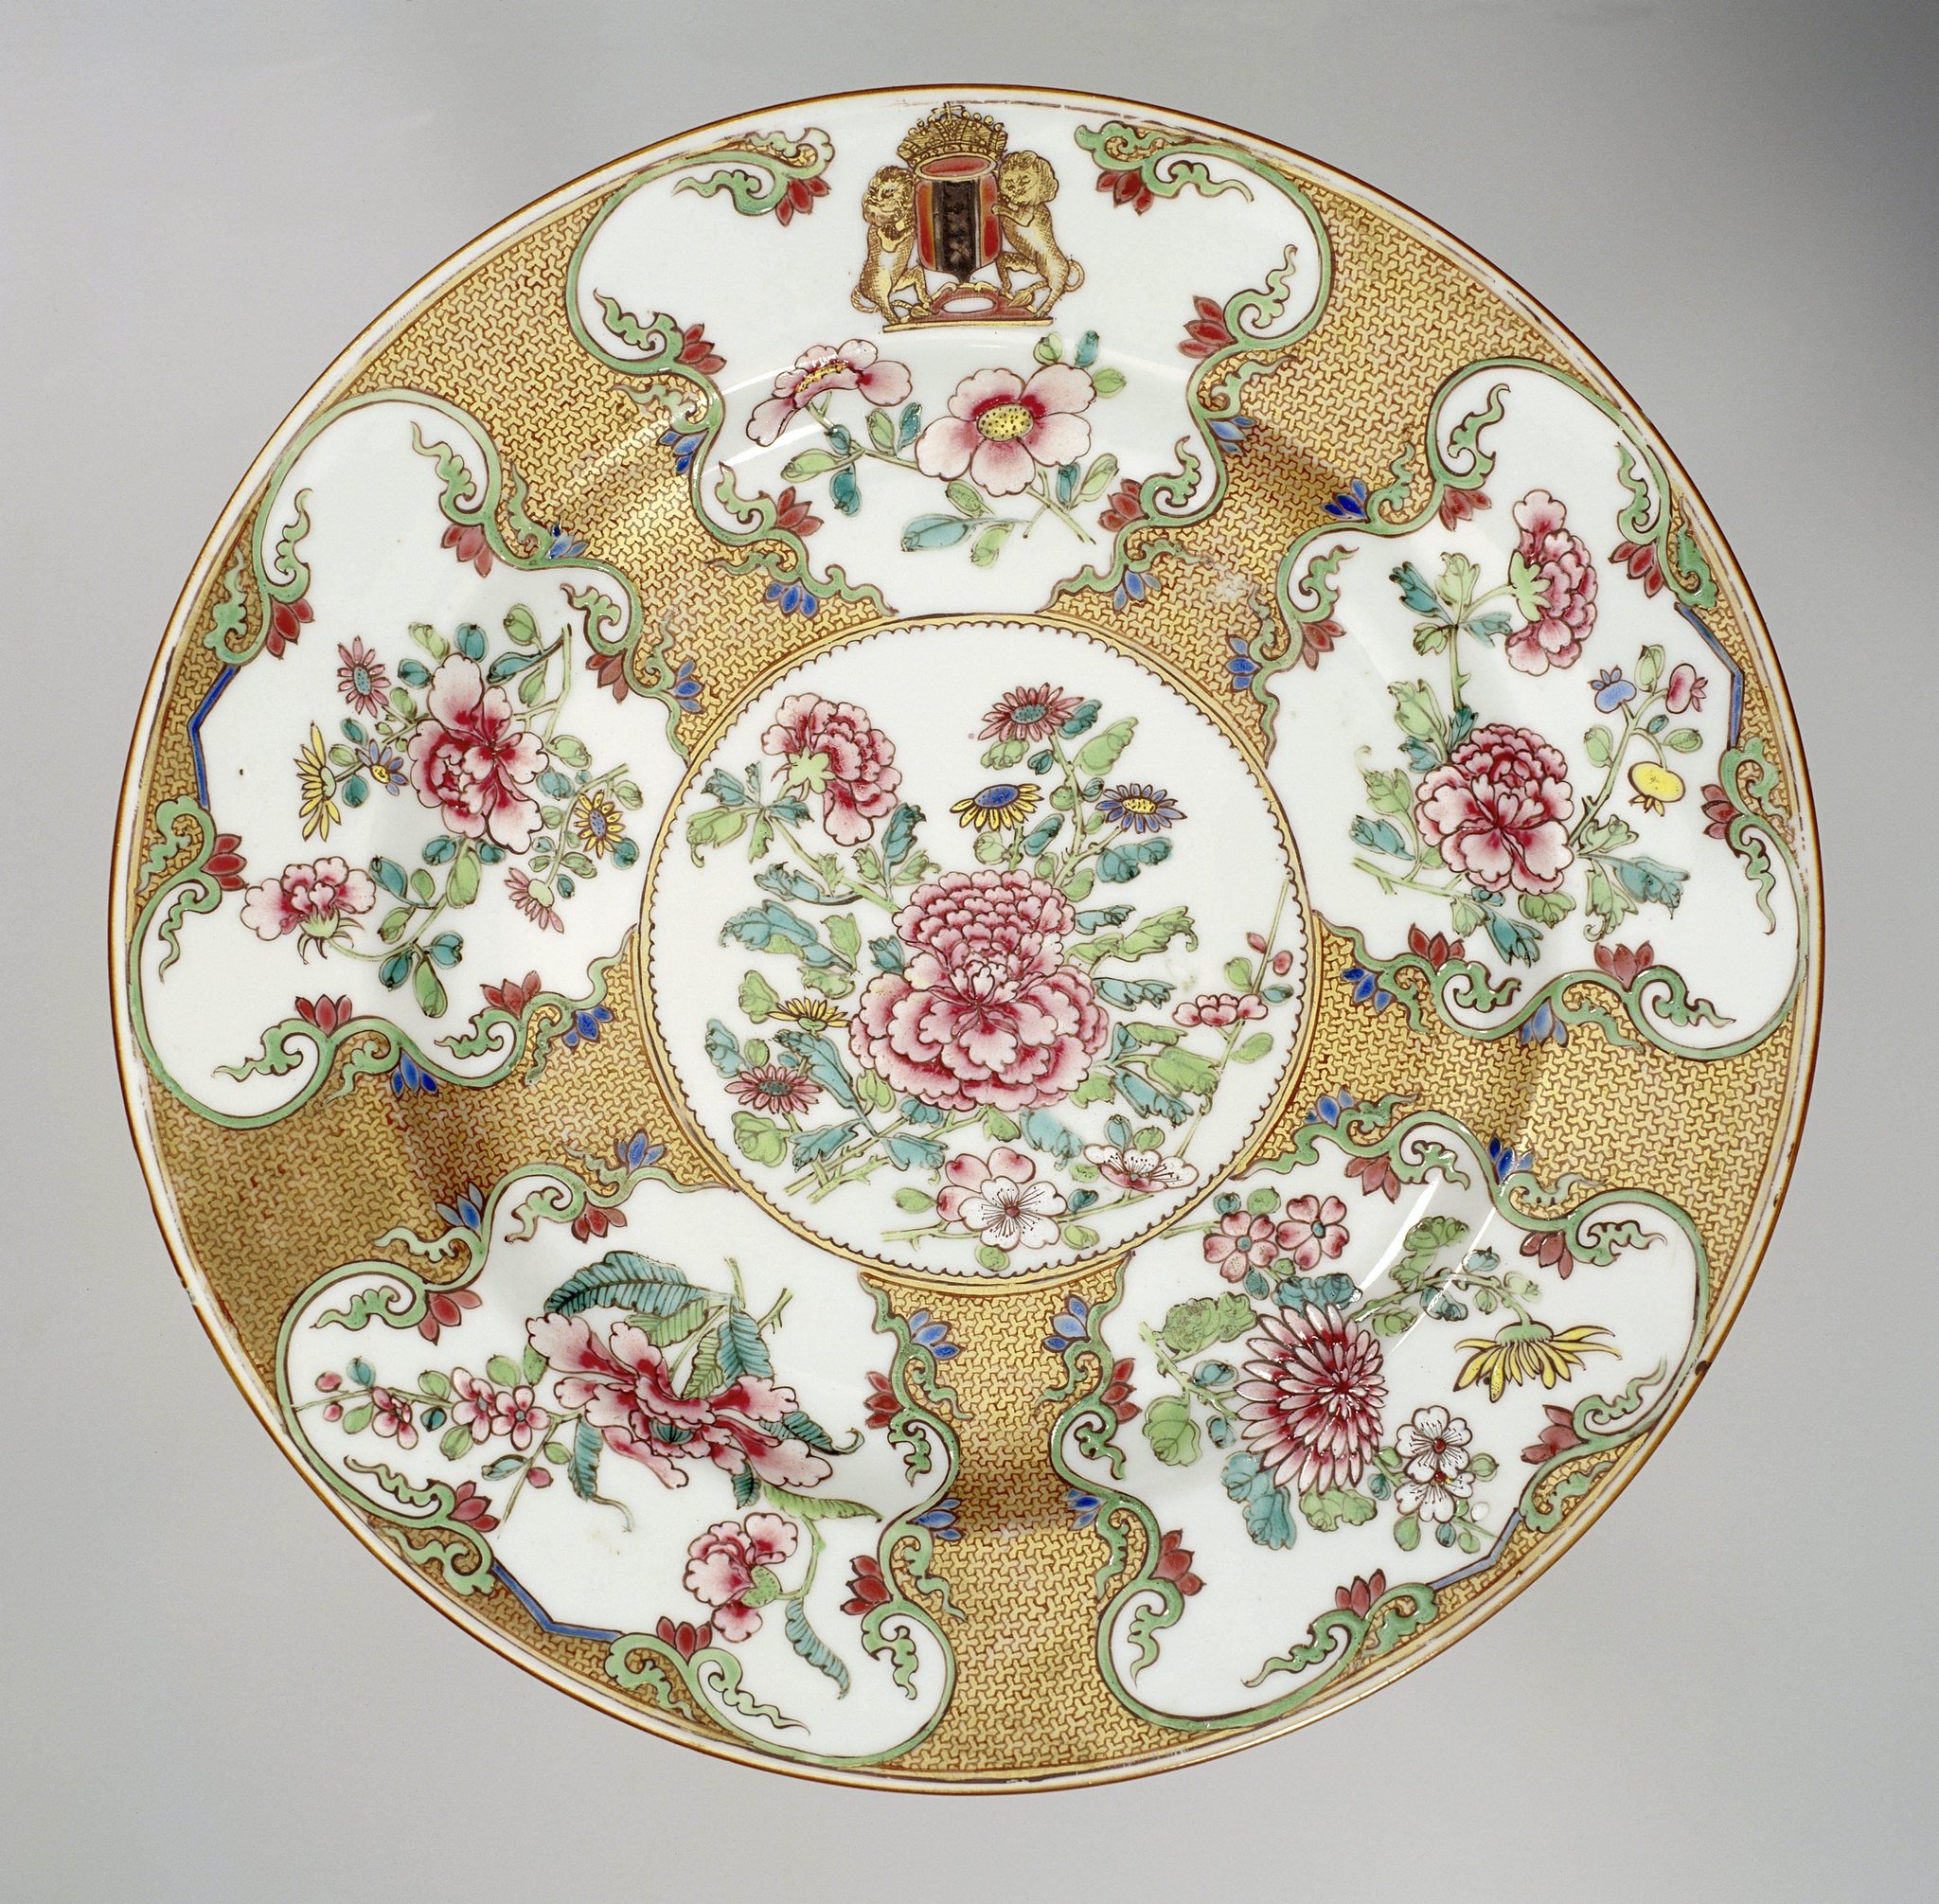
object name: plate dish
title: Plate with the Amsterdam coat of arms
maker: Anonymous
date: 1730-1740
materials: glaze, gold, paint, porcelain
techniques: firing, gilding, turning, vitrification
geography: china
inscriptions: label: ‘Scilhas Price coll/ Christies May 1906/ [...]’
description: The quality of this plate is superb. The porcelain is extremely thin, and the back is covered entirely with a ruby-pink glaze (ruby back). The front is decorated with painstakingly painted floral motifs and a geometric pattern. A fairly small Amsterdam coat of arms is depicted in the rim at the top.